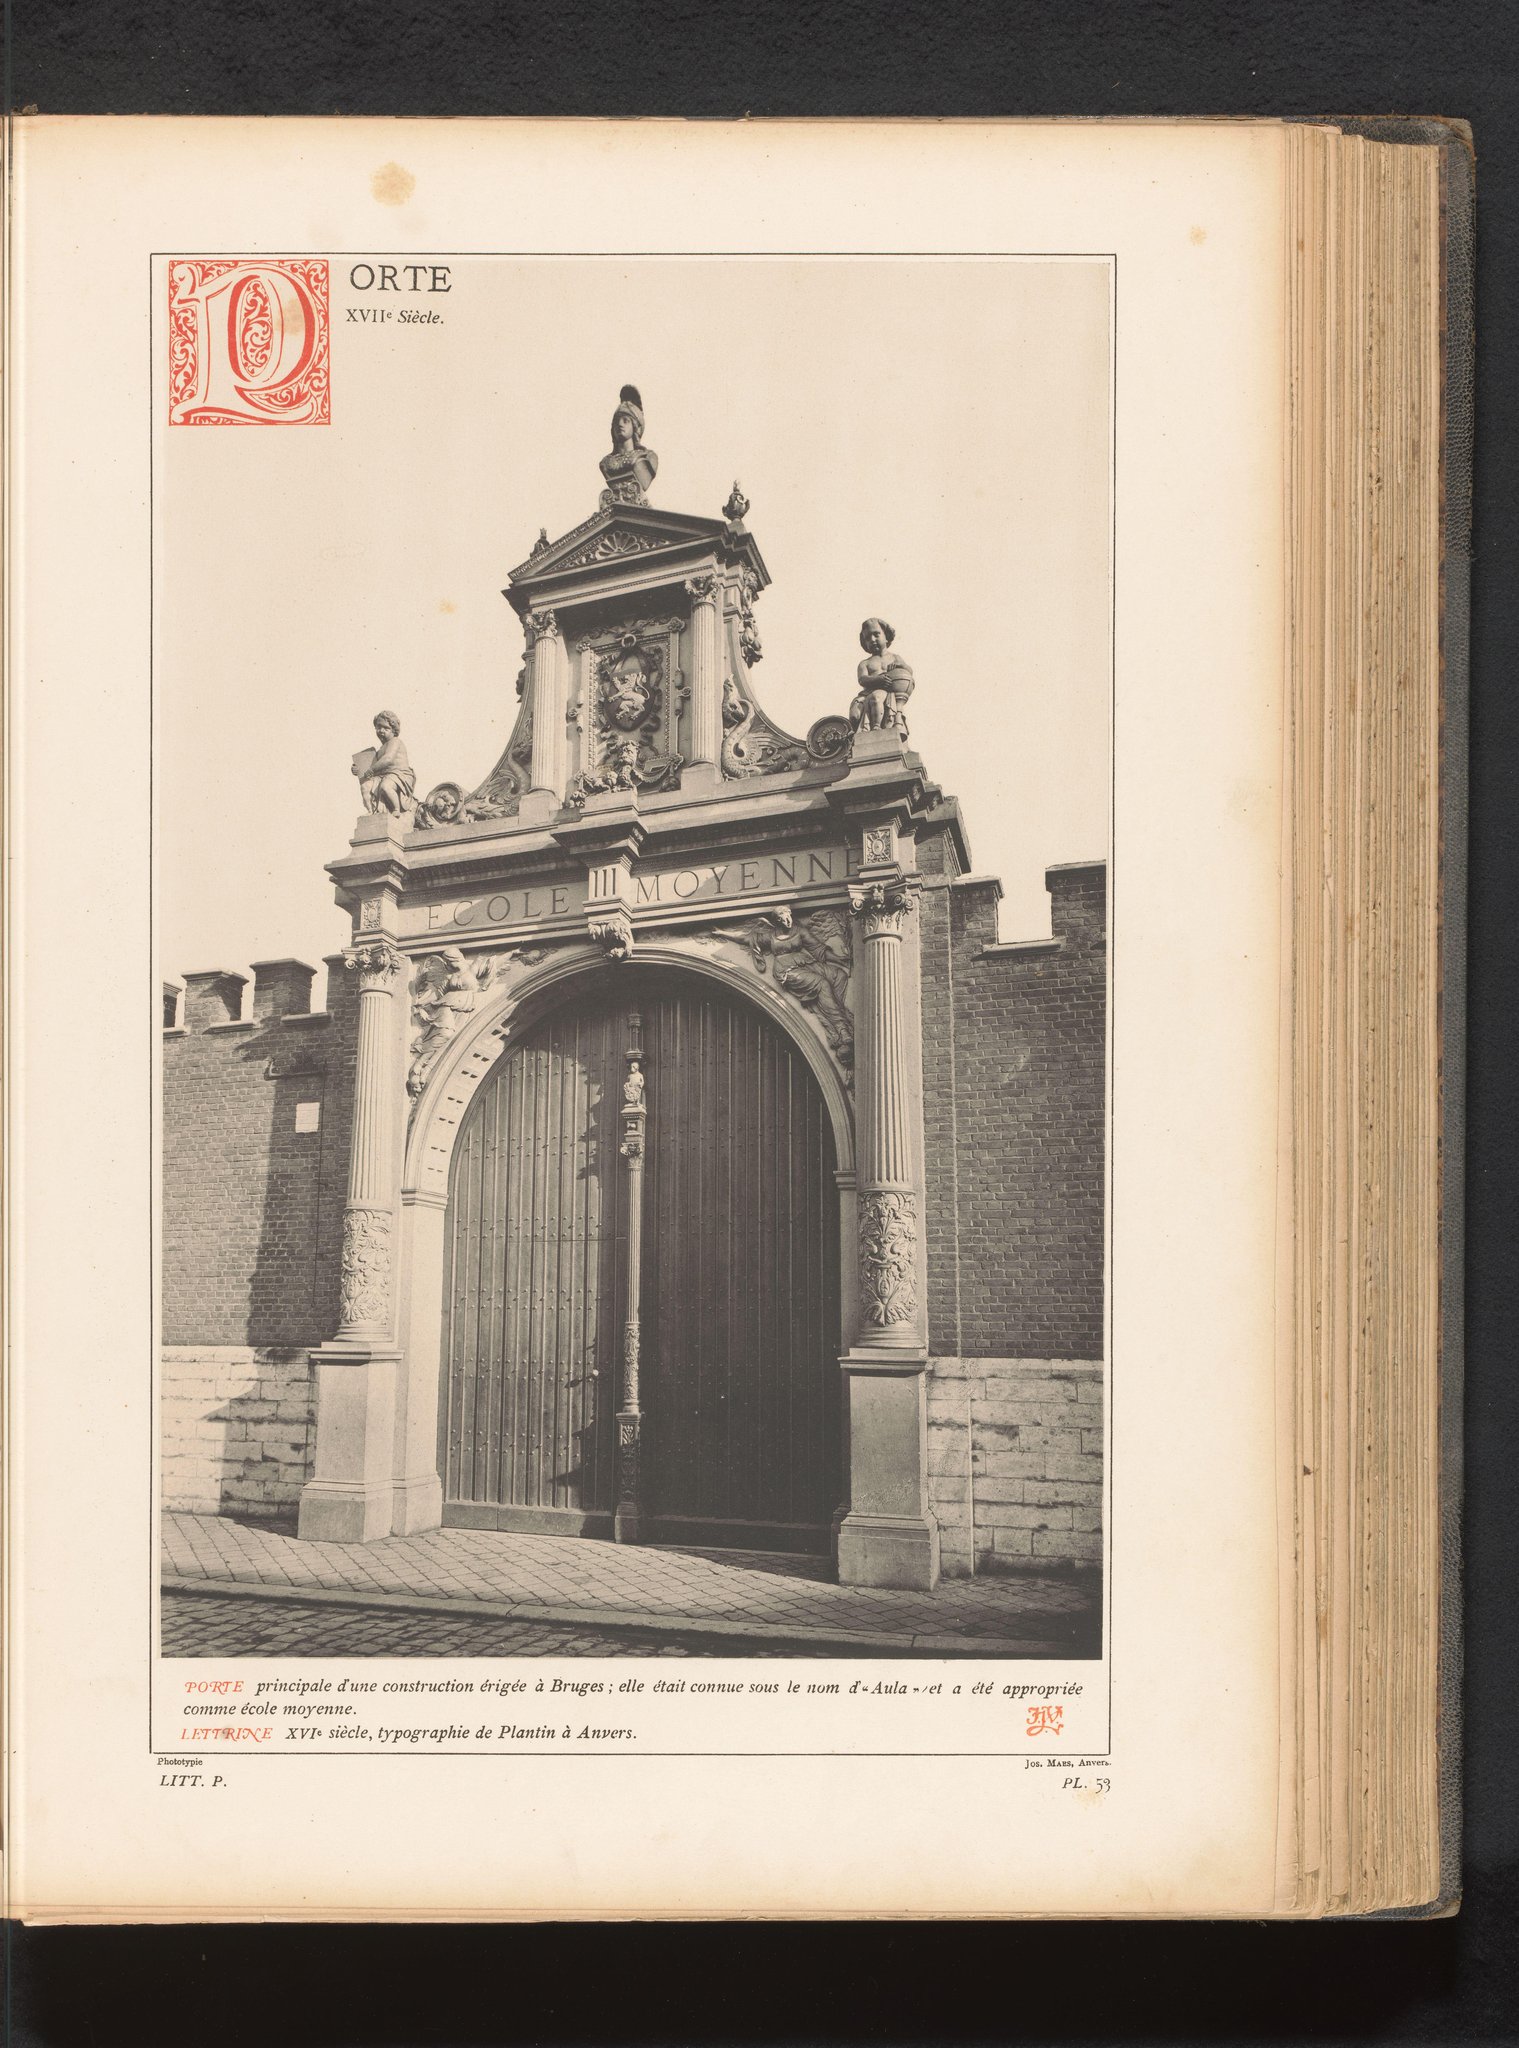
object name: page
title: Porte, XVIe Siècle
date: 1876-1881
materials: paper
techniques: photograph, photolithography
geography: antwerp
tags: gate, entrance, bruges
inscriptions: inscription: ‘LITT. P. - PL. 32.’, inscription: ‘PORTAIL principale d'une construction (...)’, monogram: ‘JJvY’